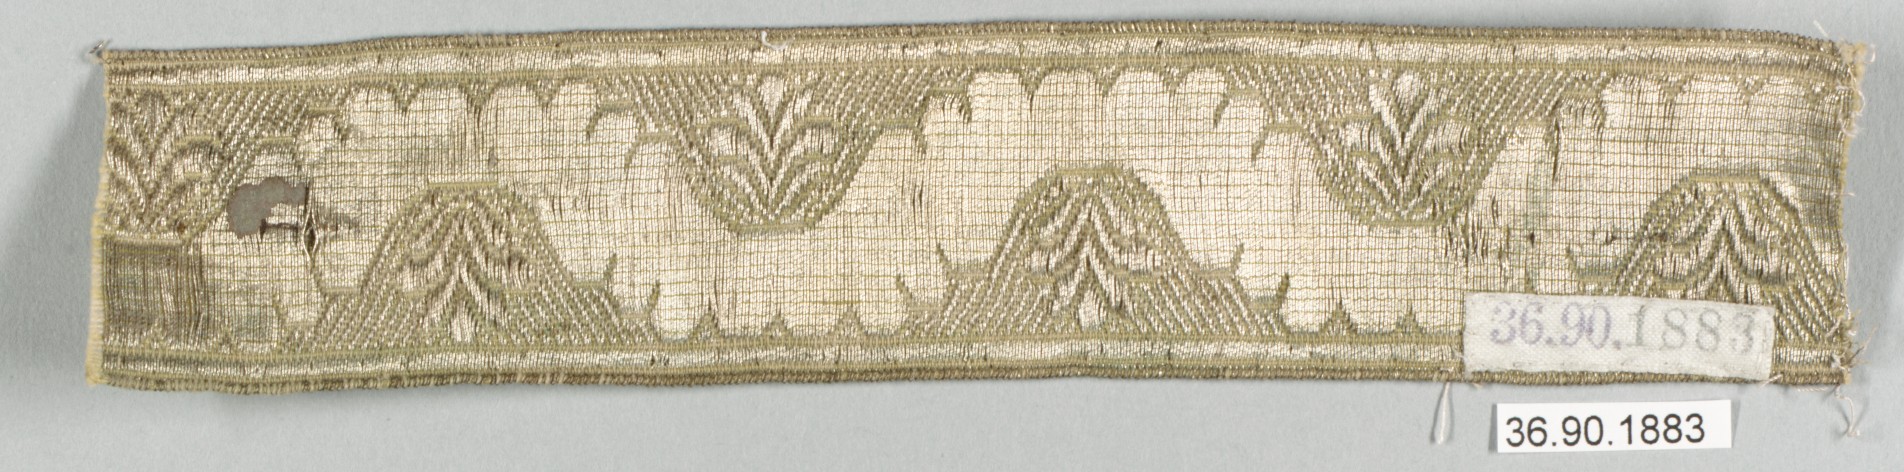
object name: galloon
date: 1767-1833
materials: metal thread, silk